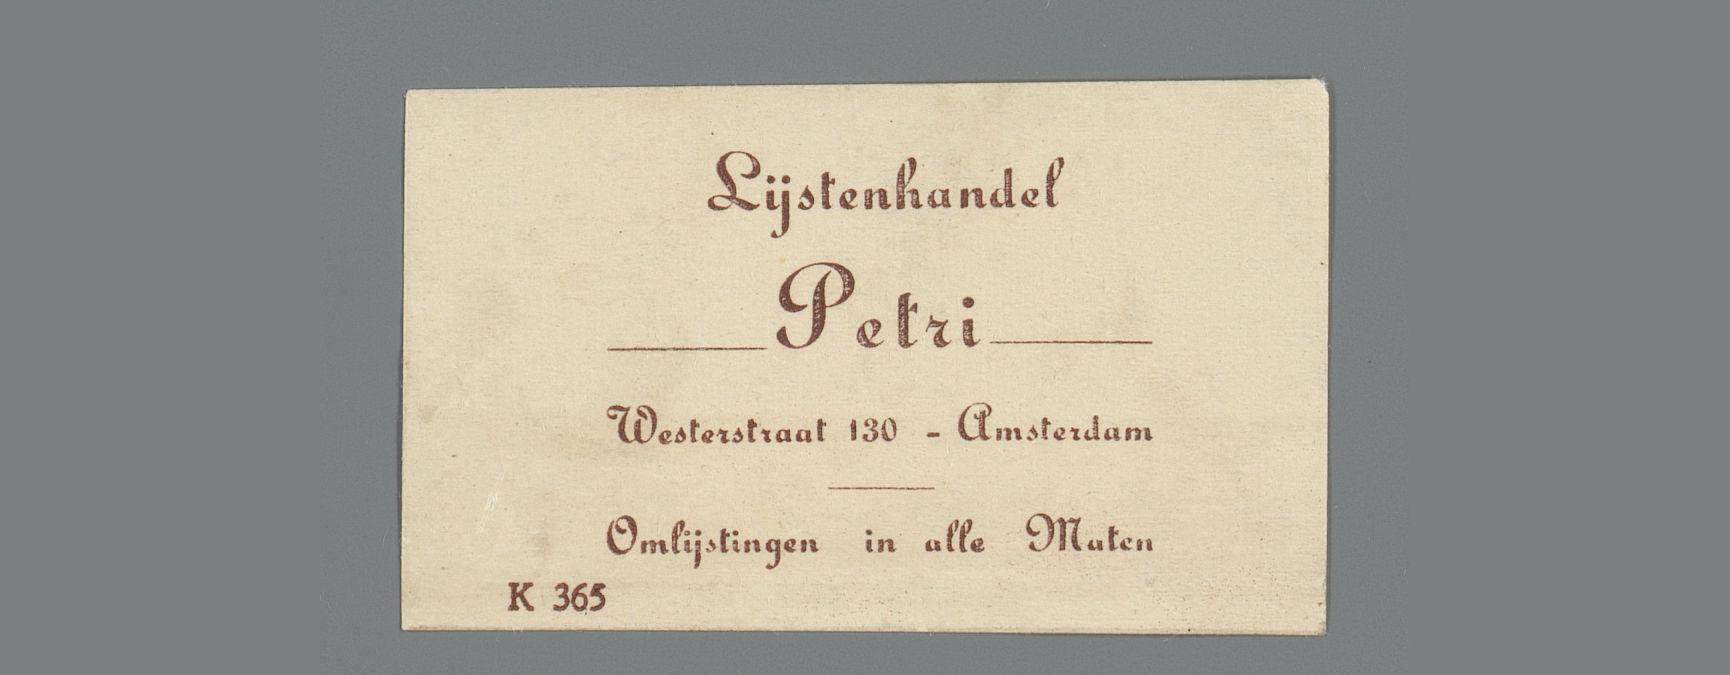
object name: business card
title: Adreskaart van lijstenhandel Petri te Amsterdam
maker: Anonymous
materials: paper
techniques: letterpress printing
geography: amsterdam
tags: printed matter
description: Bij gebrek aan gegevens over de vervaardiger is voor de bepaling van de rechten van dit object gebruik gemaakt van de vervaardigingsdatum.